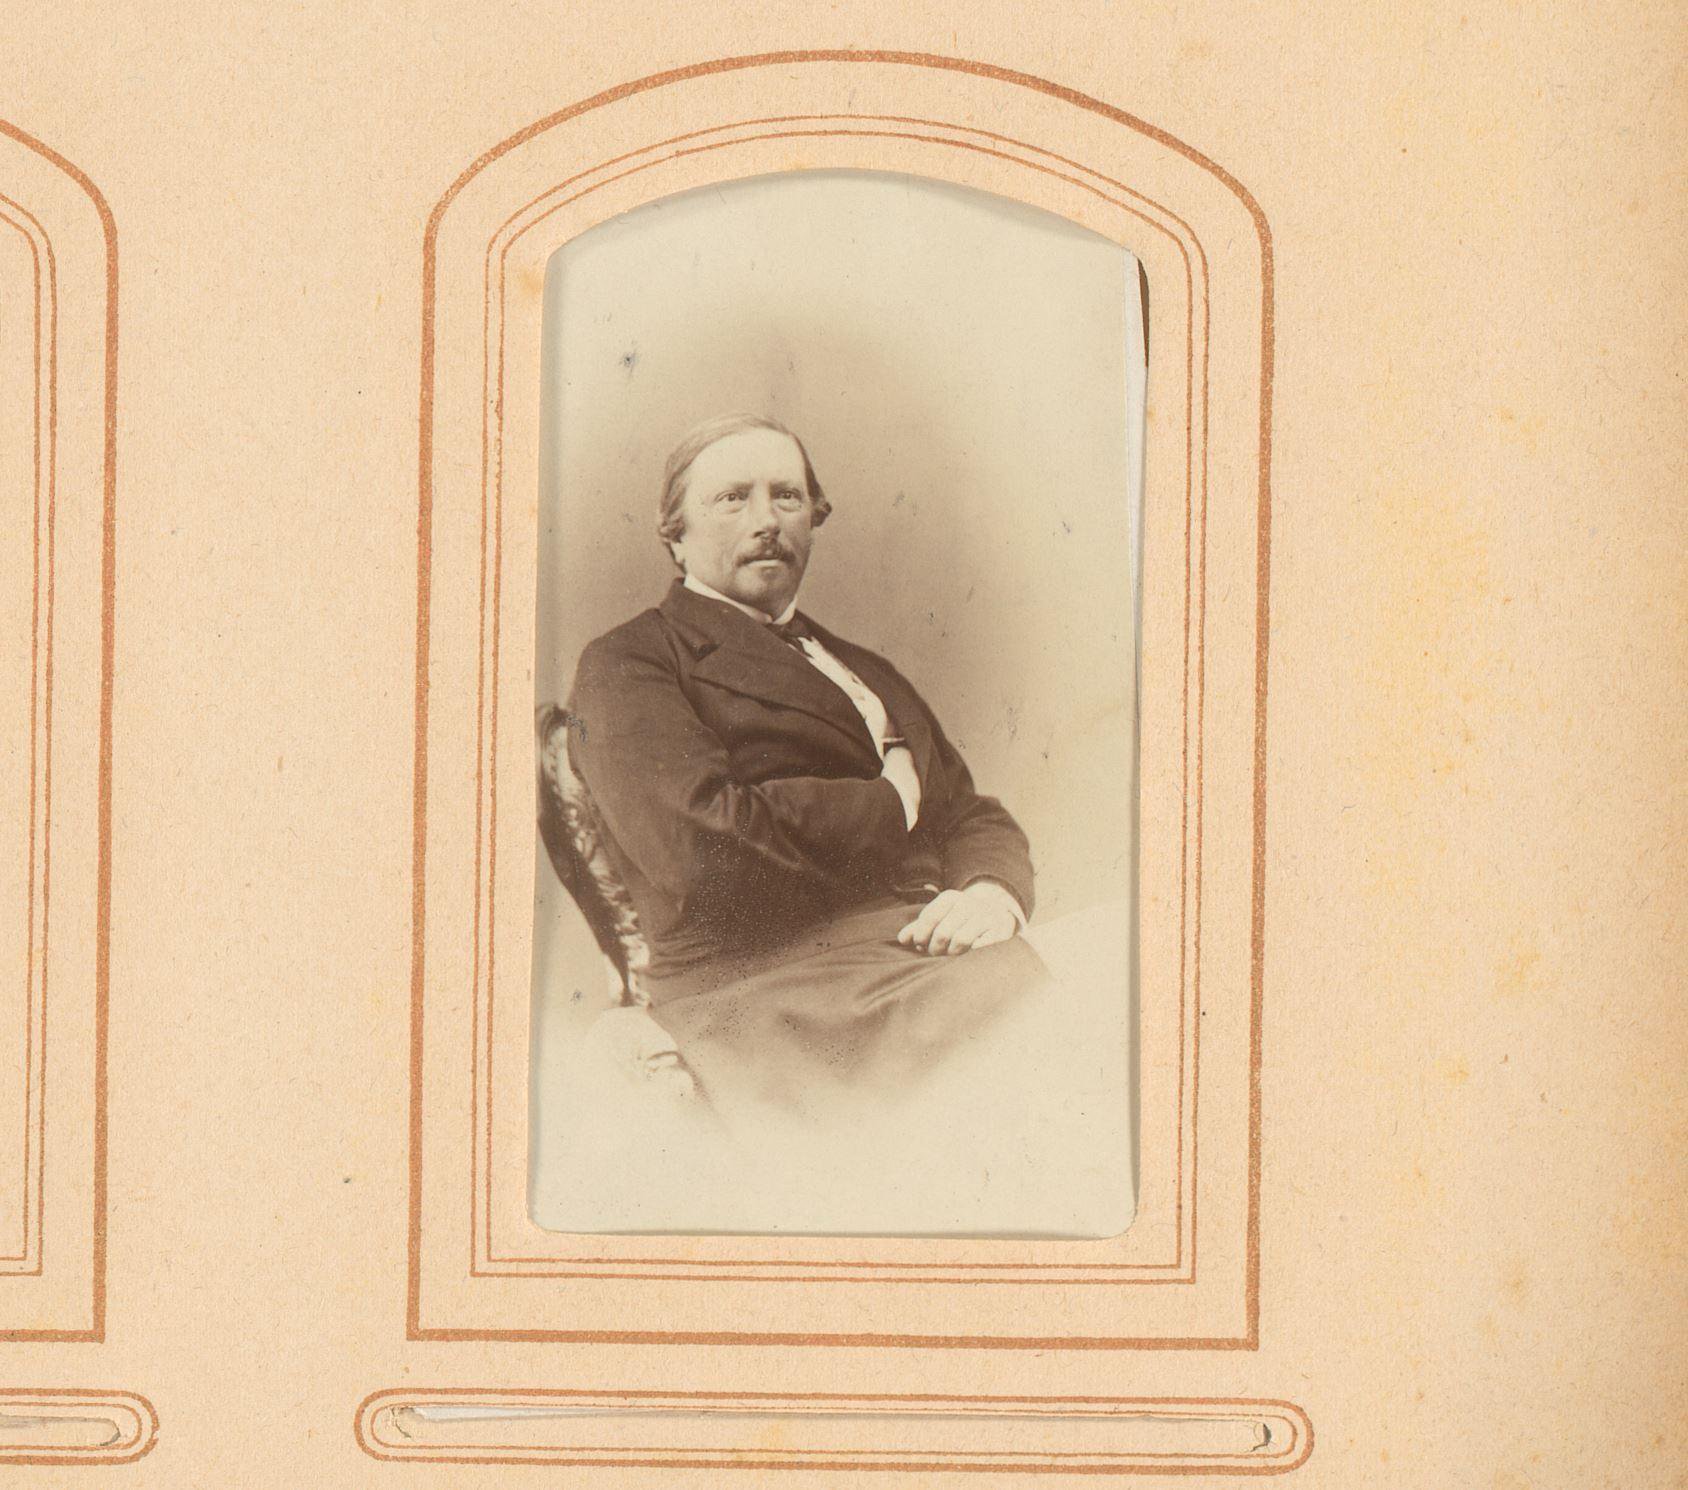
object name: album leaf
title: Portret van een zittende man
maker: jacob lundbergh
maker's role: fotograaf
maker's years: 1828-1904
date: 1855-1890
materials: cardboard, photographic support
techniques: albumen print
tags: sitting figure, moustache, adult man, historical persons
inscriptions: annotation: ‘[...]/ 1822-1896’, inscription: ‘J. Lundbergh/ Fotograf/ Göthgatan/ No. 4 Urvädersgatan No. 4/ Stockholm’